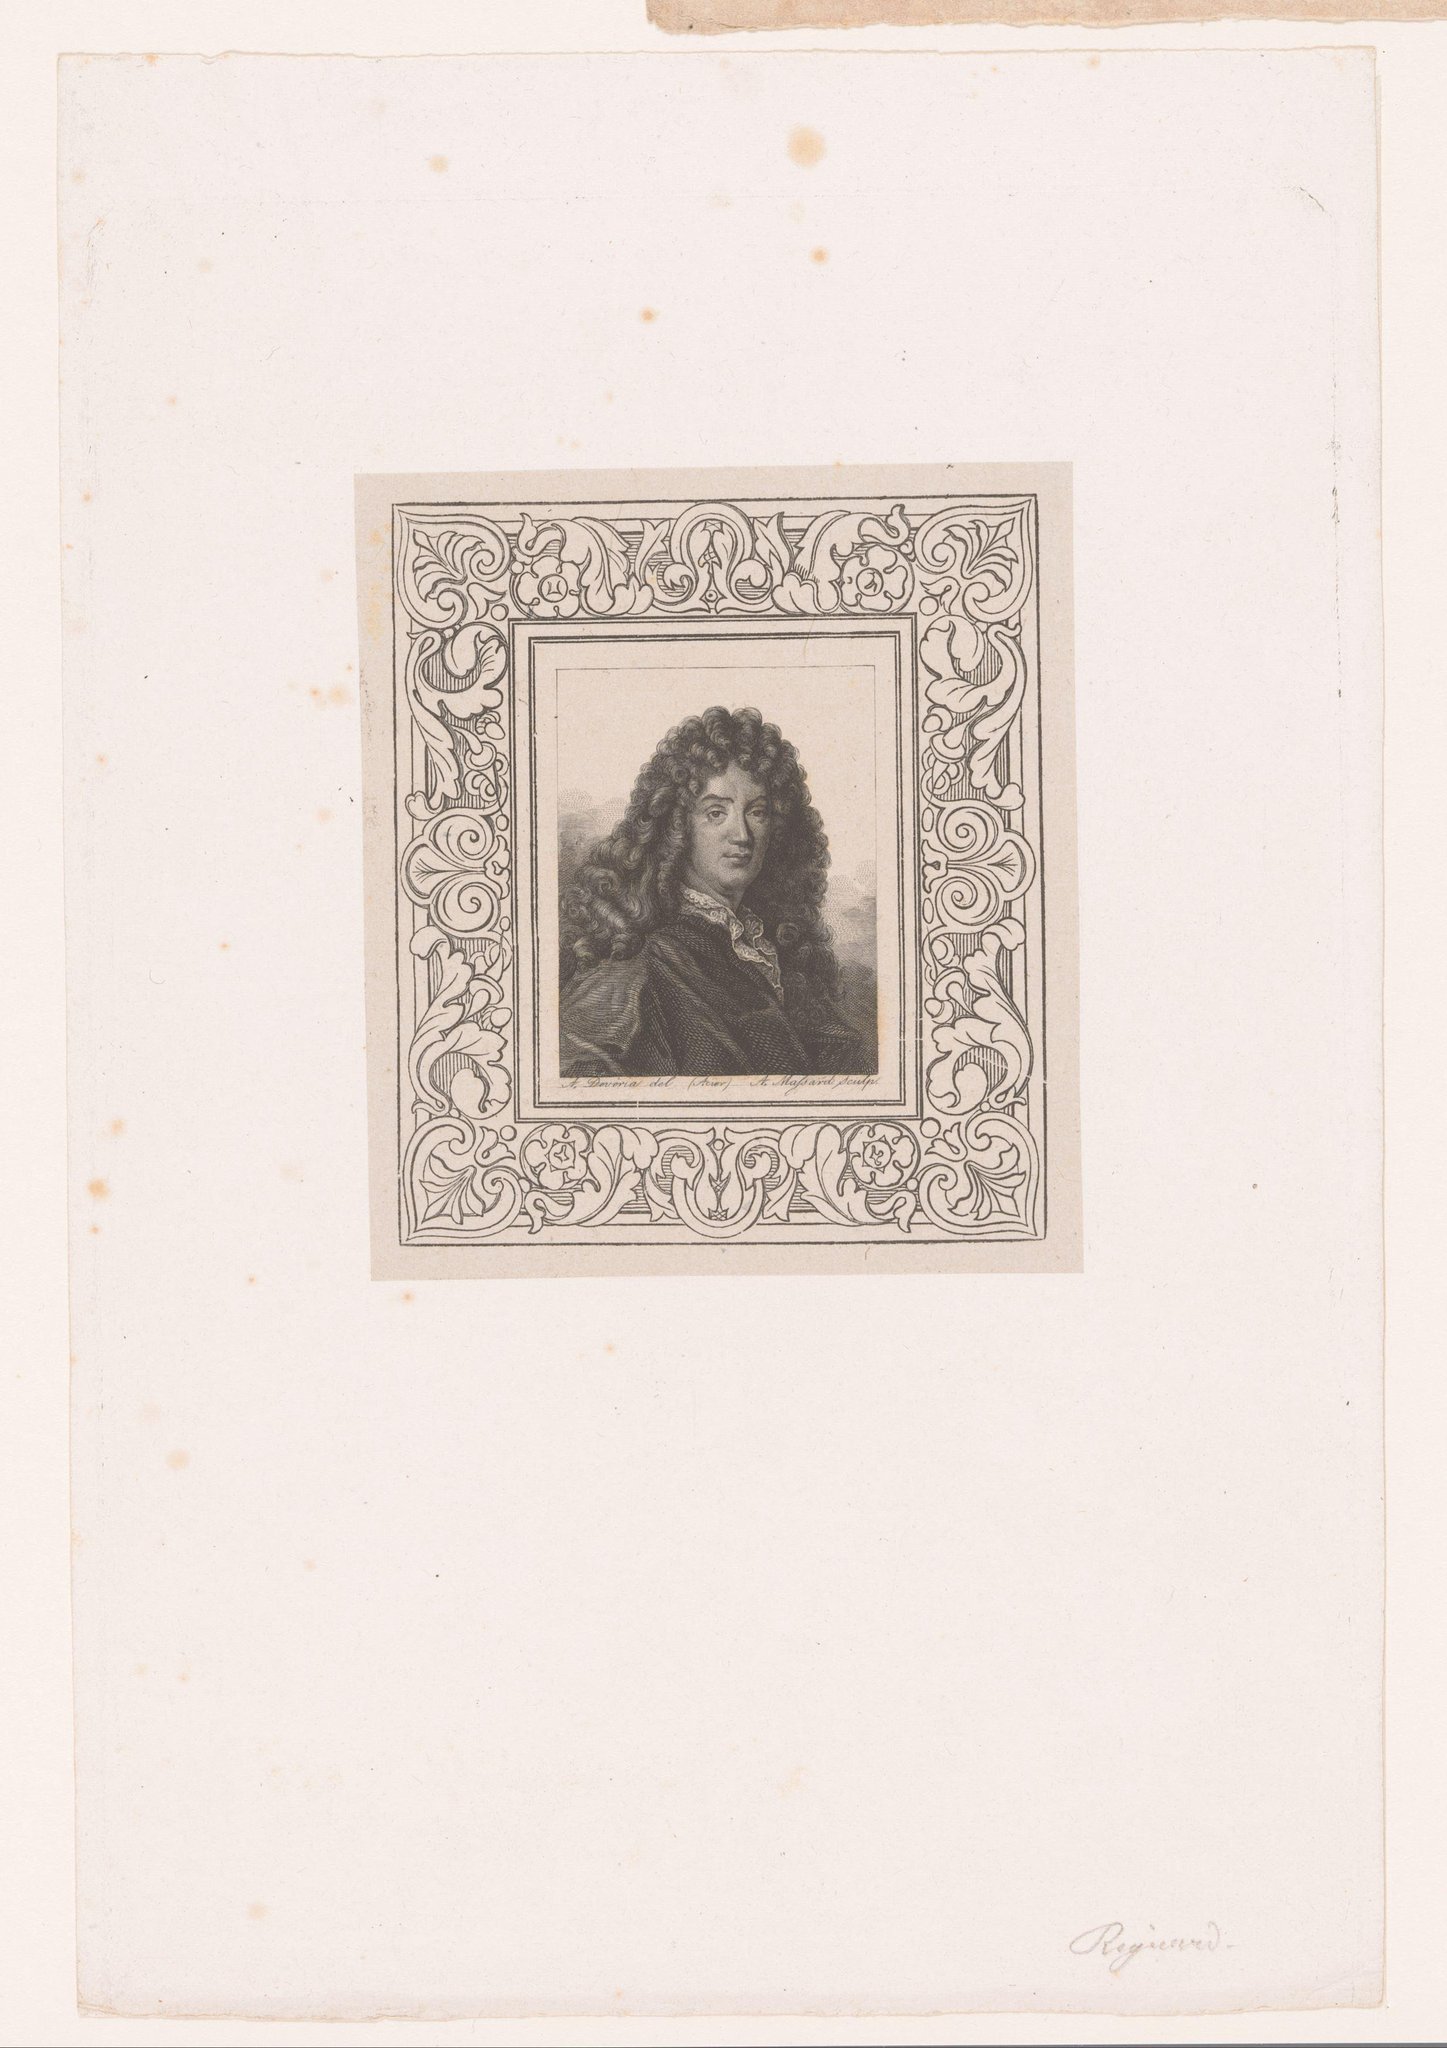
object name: print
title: Portret van Jean-François Regnard in ornamentale lijst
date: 1787-1887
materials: paper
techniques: engraving, etching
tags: paris, historical persons, portrait of a writer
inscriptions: collector's mark: Lugt 2228